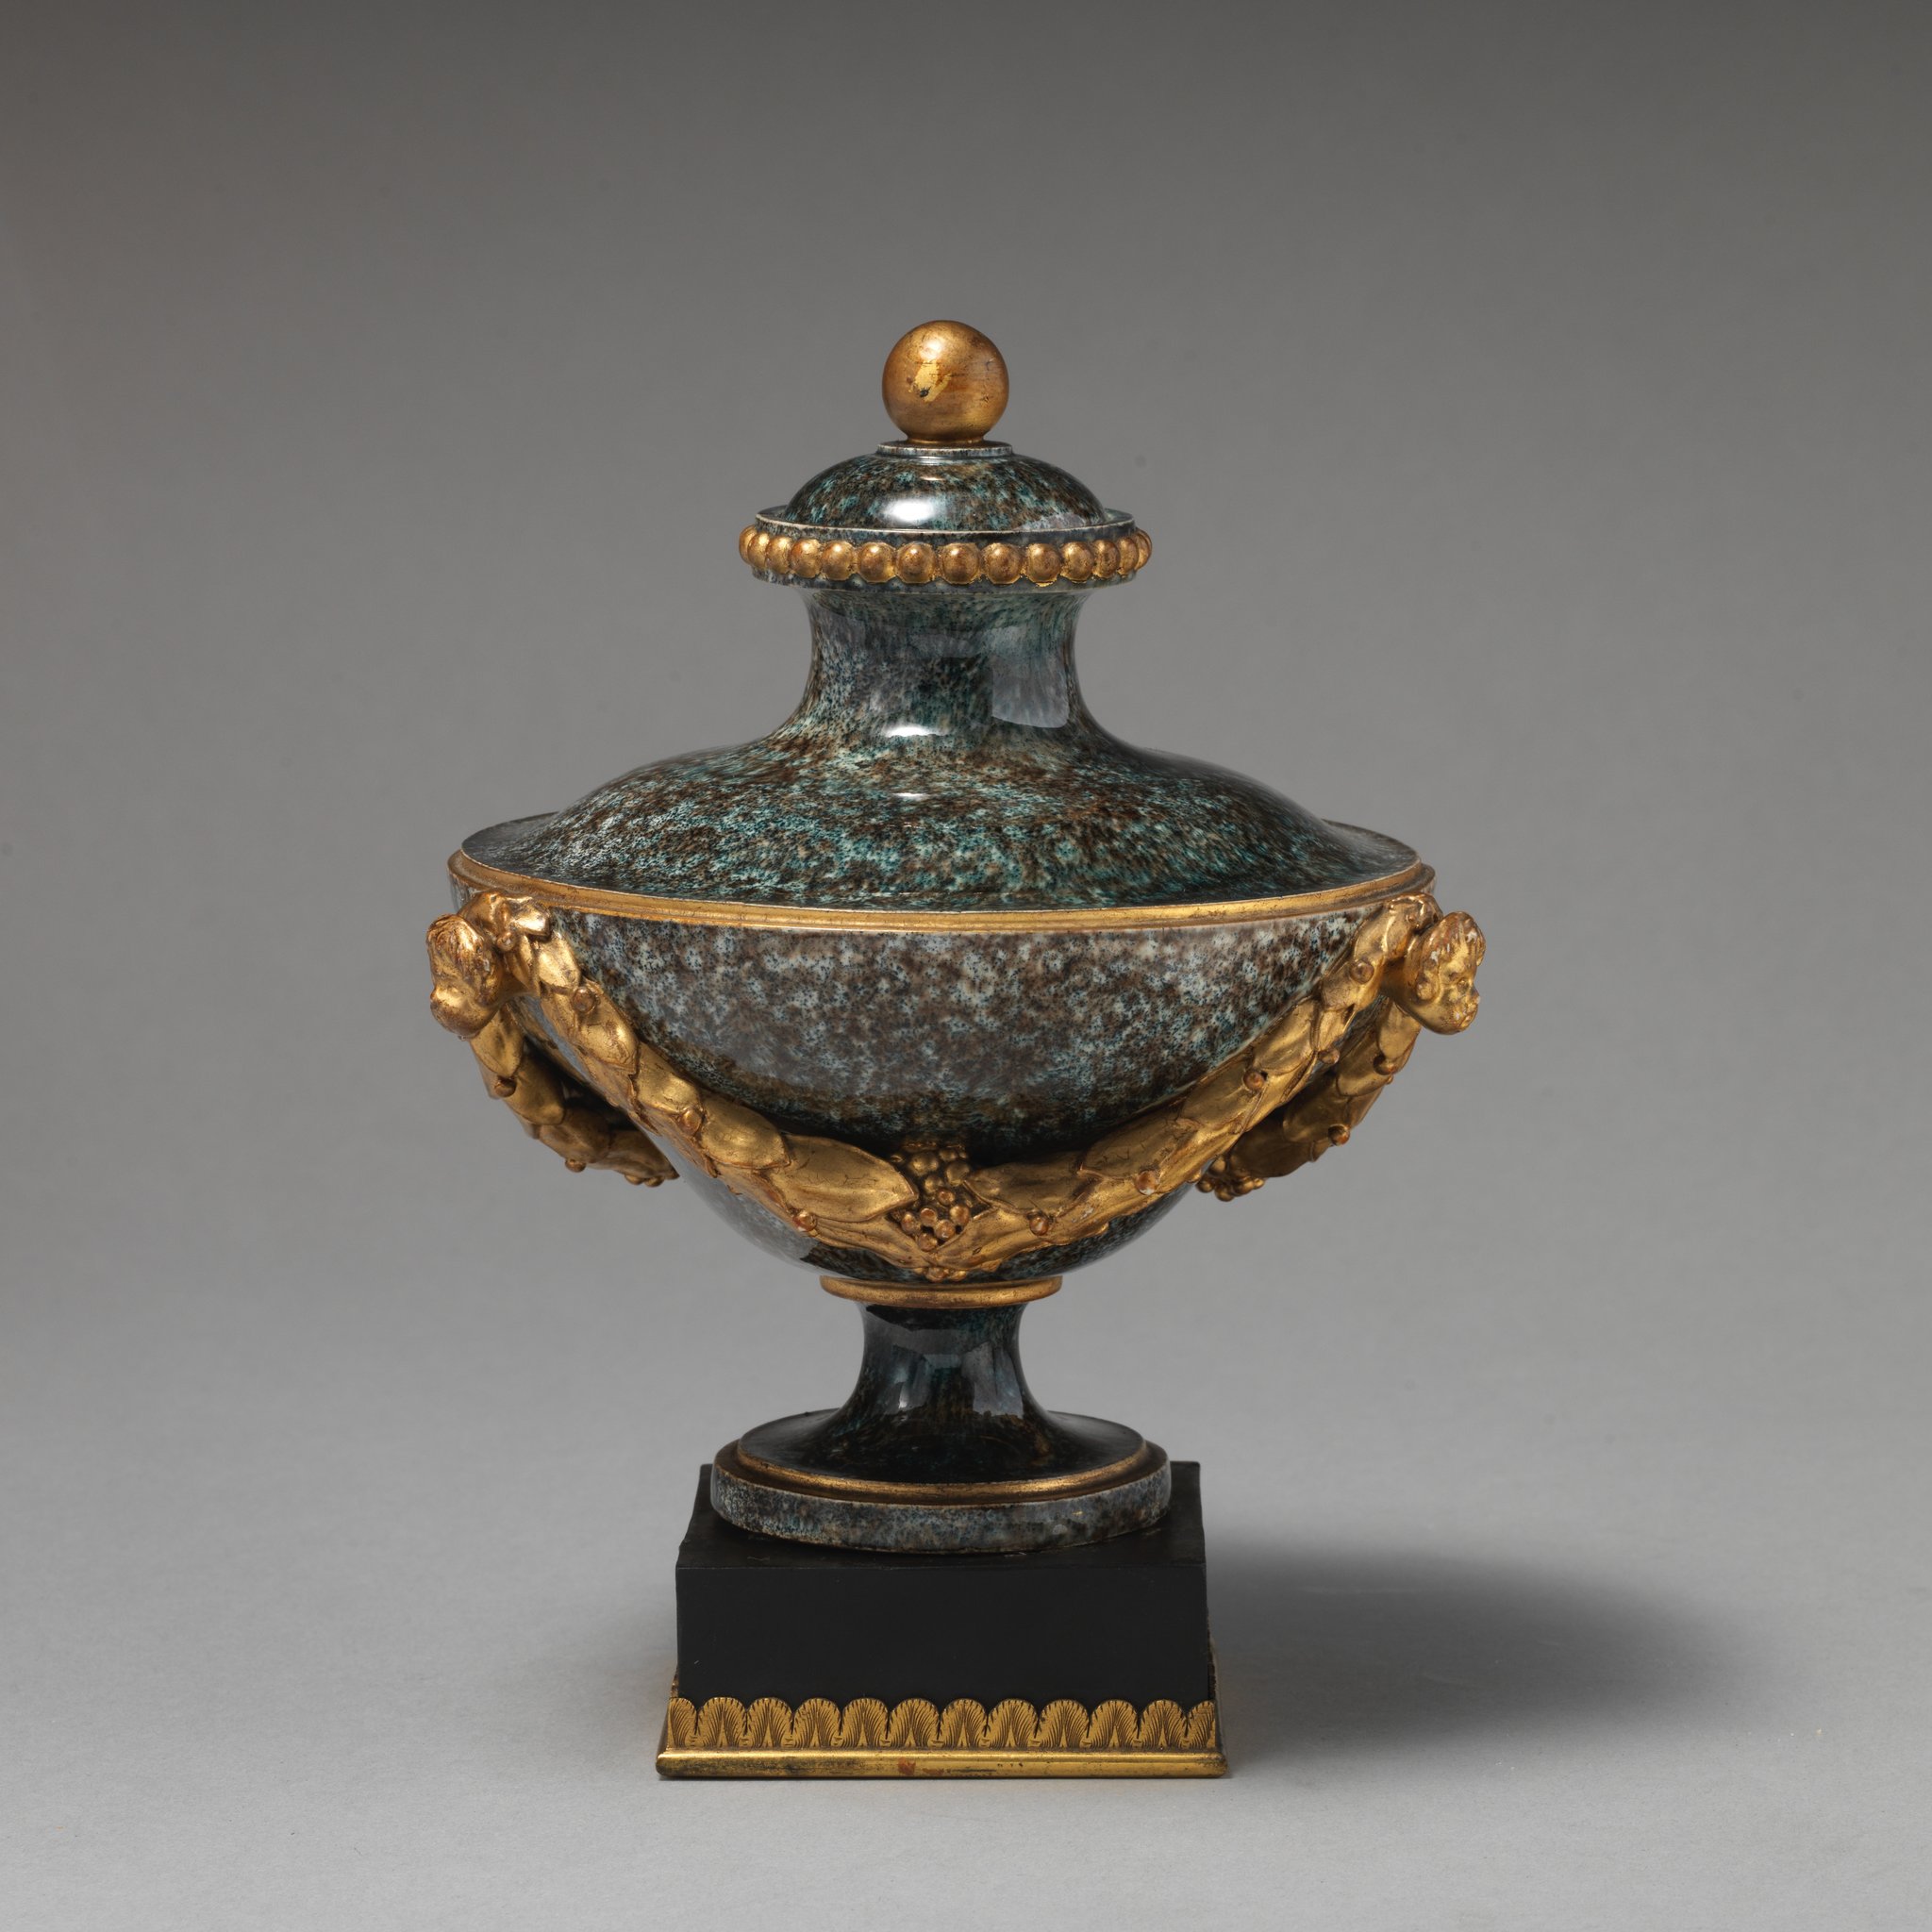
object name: vase with cover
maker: wedgwood and bentley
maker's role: factory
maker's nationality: british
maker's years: 1769-1780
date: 1769-1780